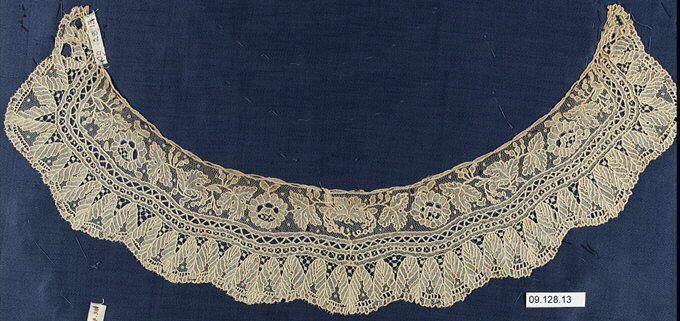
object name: collar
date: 1801-1900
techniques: lace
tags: flowers